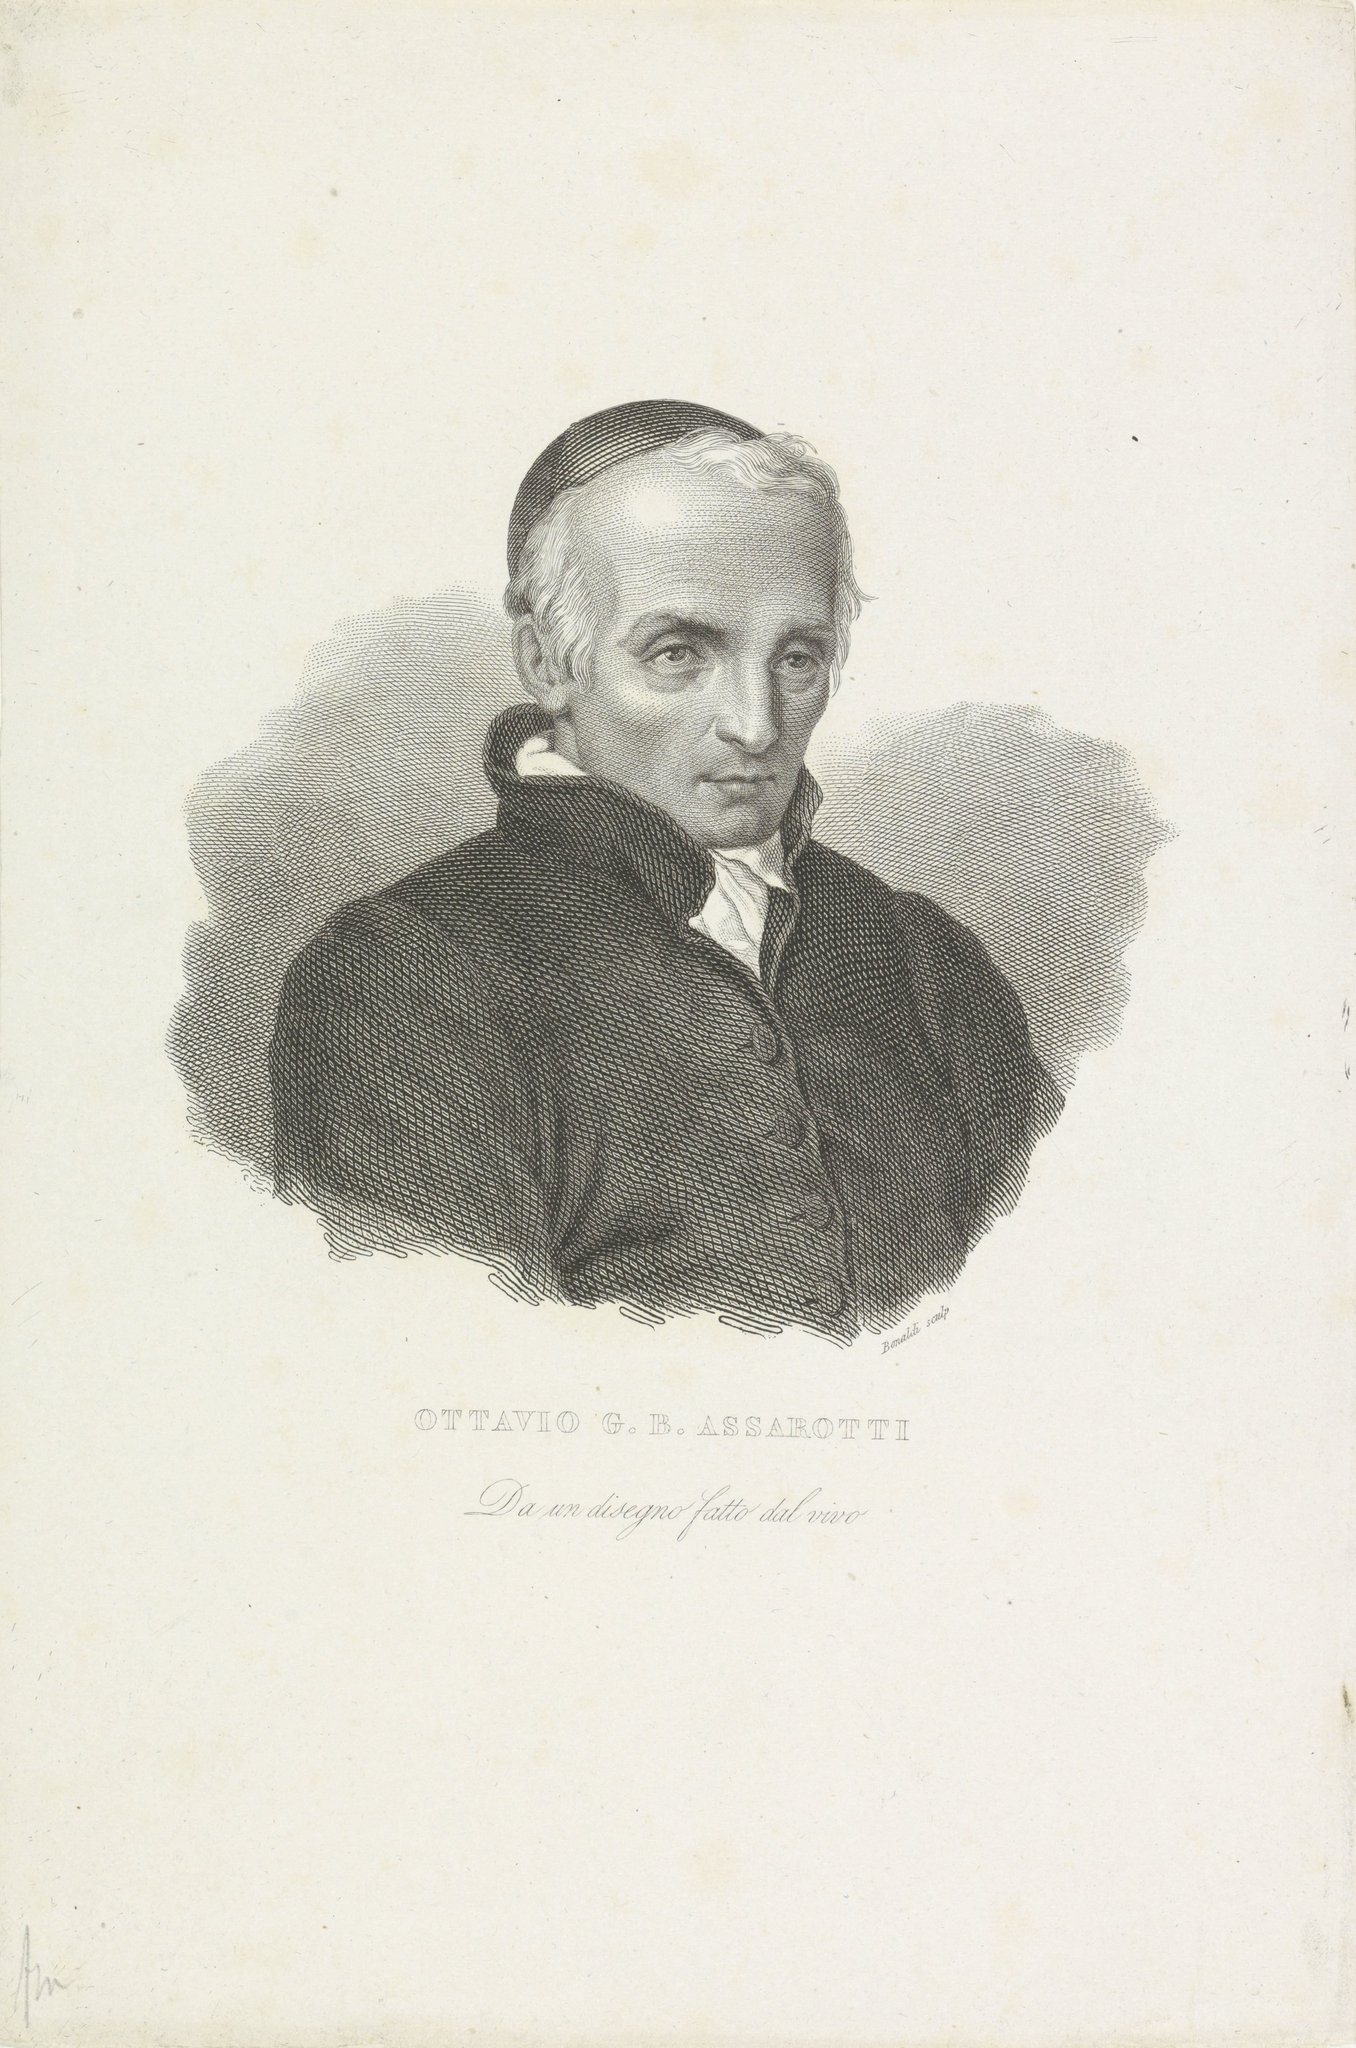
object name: print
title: Portret van Ottavio Giovanni Battista Assarotti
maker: giovanni a. bonaldi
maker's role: print maker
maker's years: 1804-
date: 1814-1829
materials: paper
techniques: engraving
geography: italy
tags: historical persons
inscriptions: collector's mark: Lugt 2228